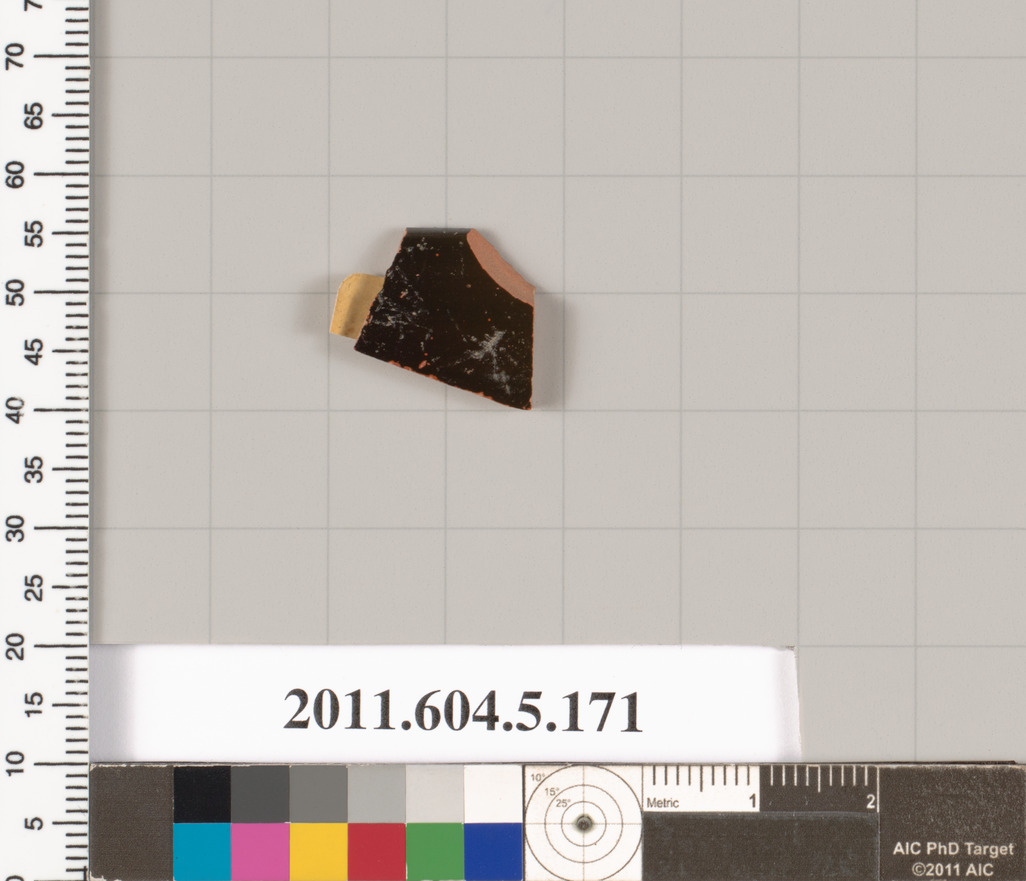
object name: kylix fragment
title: Terracotta rim fragment of a kylix (drinking cup)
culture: greek, attic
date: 600-401 BCE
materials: terracotta